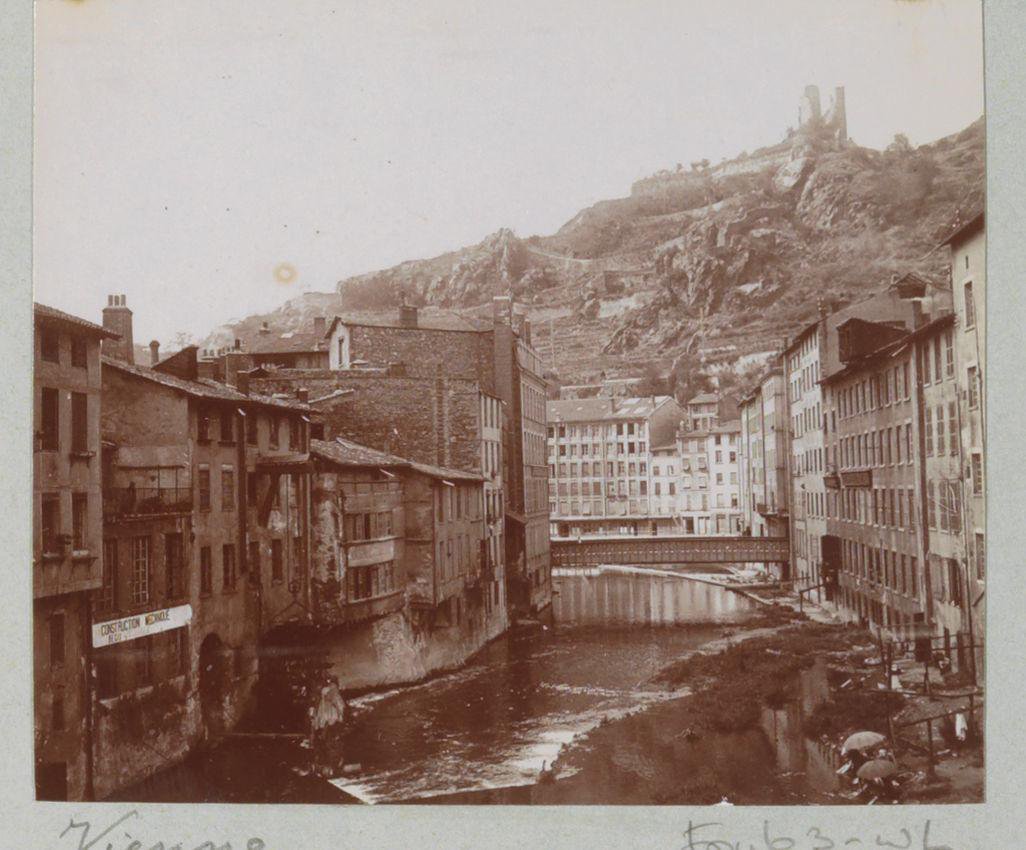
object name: photograph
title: Gezicht op Vienne met huizen langs een rivier en (rechtsboven) de ruïne van het Château de La Batie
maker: delizy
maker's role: manufacturer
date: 1904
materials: paper, photographic support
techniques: gelatin silver print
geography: vienne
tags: prospect of village, silhouette of village, river (+ landscape with figures, staffage), ruin of a dwelling, house, castle, etc., vienne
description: Onderdeel van Fotoalbum van een Franse amateurfotograaf met opnames van uitstapjes in Frankrijk, Spanje, België, Luxemburg en Nederland, de eerste automobielen en autoraces.